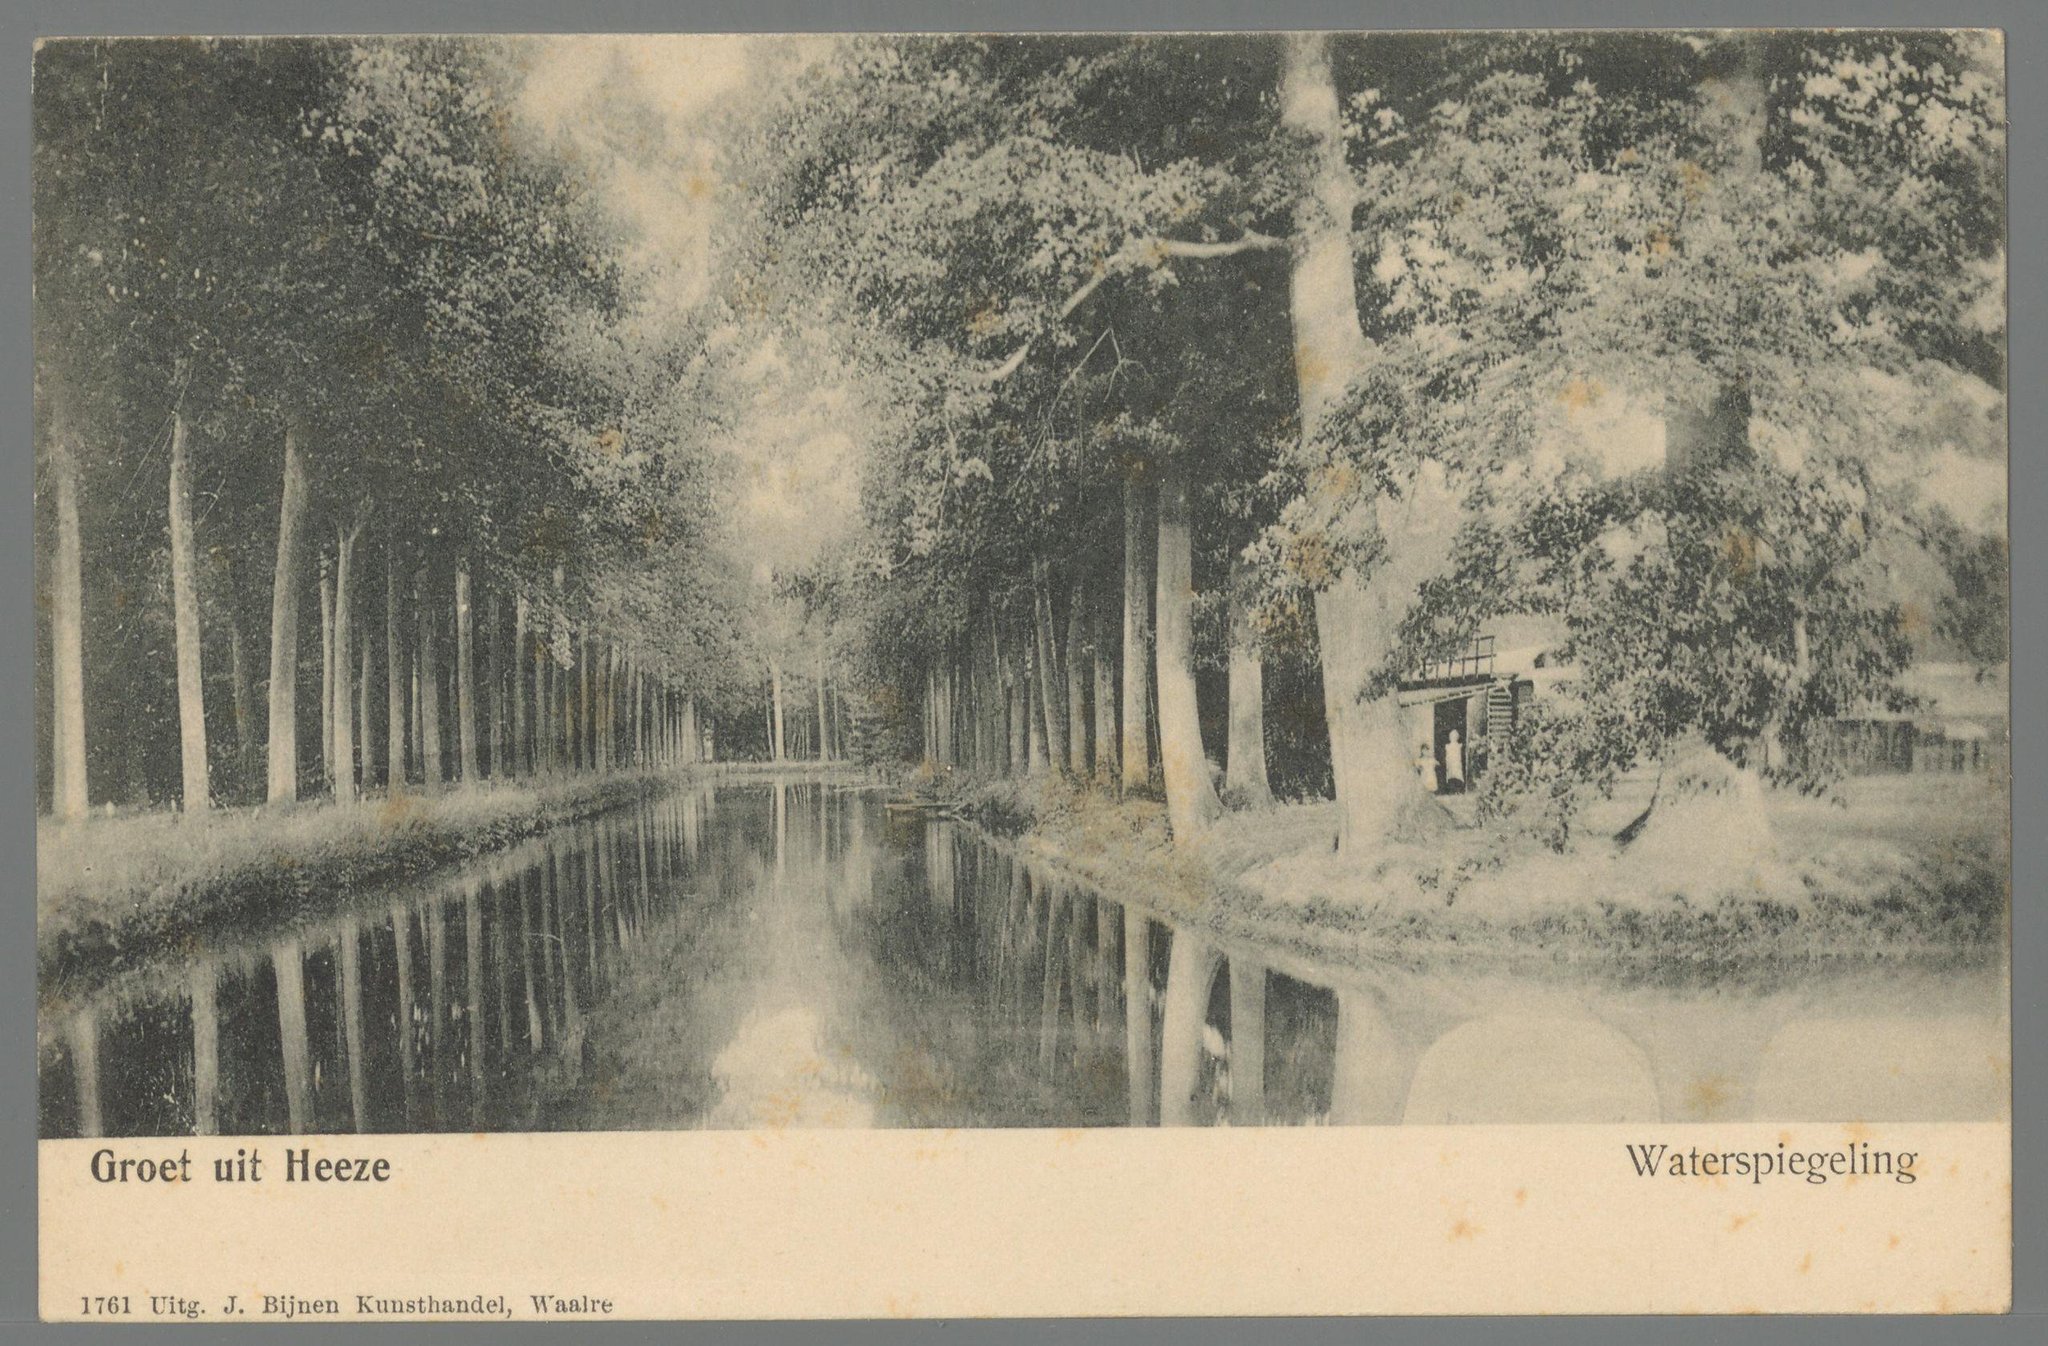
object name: ansichtkaart, prentbriefkaart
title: Groet uit Heeze. Waterspiegeling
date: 1897-1905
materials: cardboard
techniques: photograph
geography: waalre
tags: forest, wood, small canal, ditch